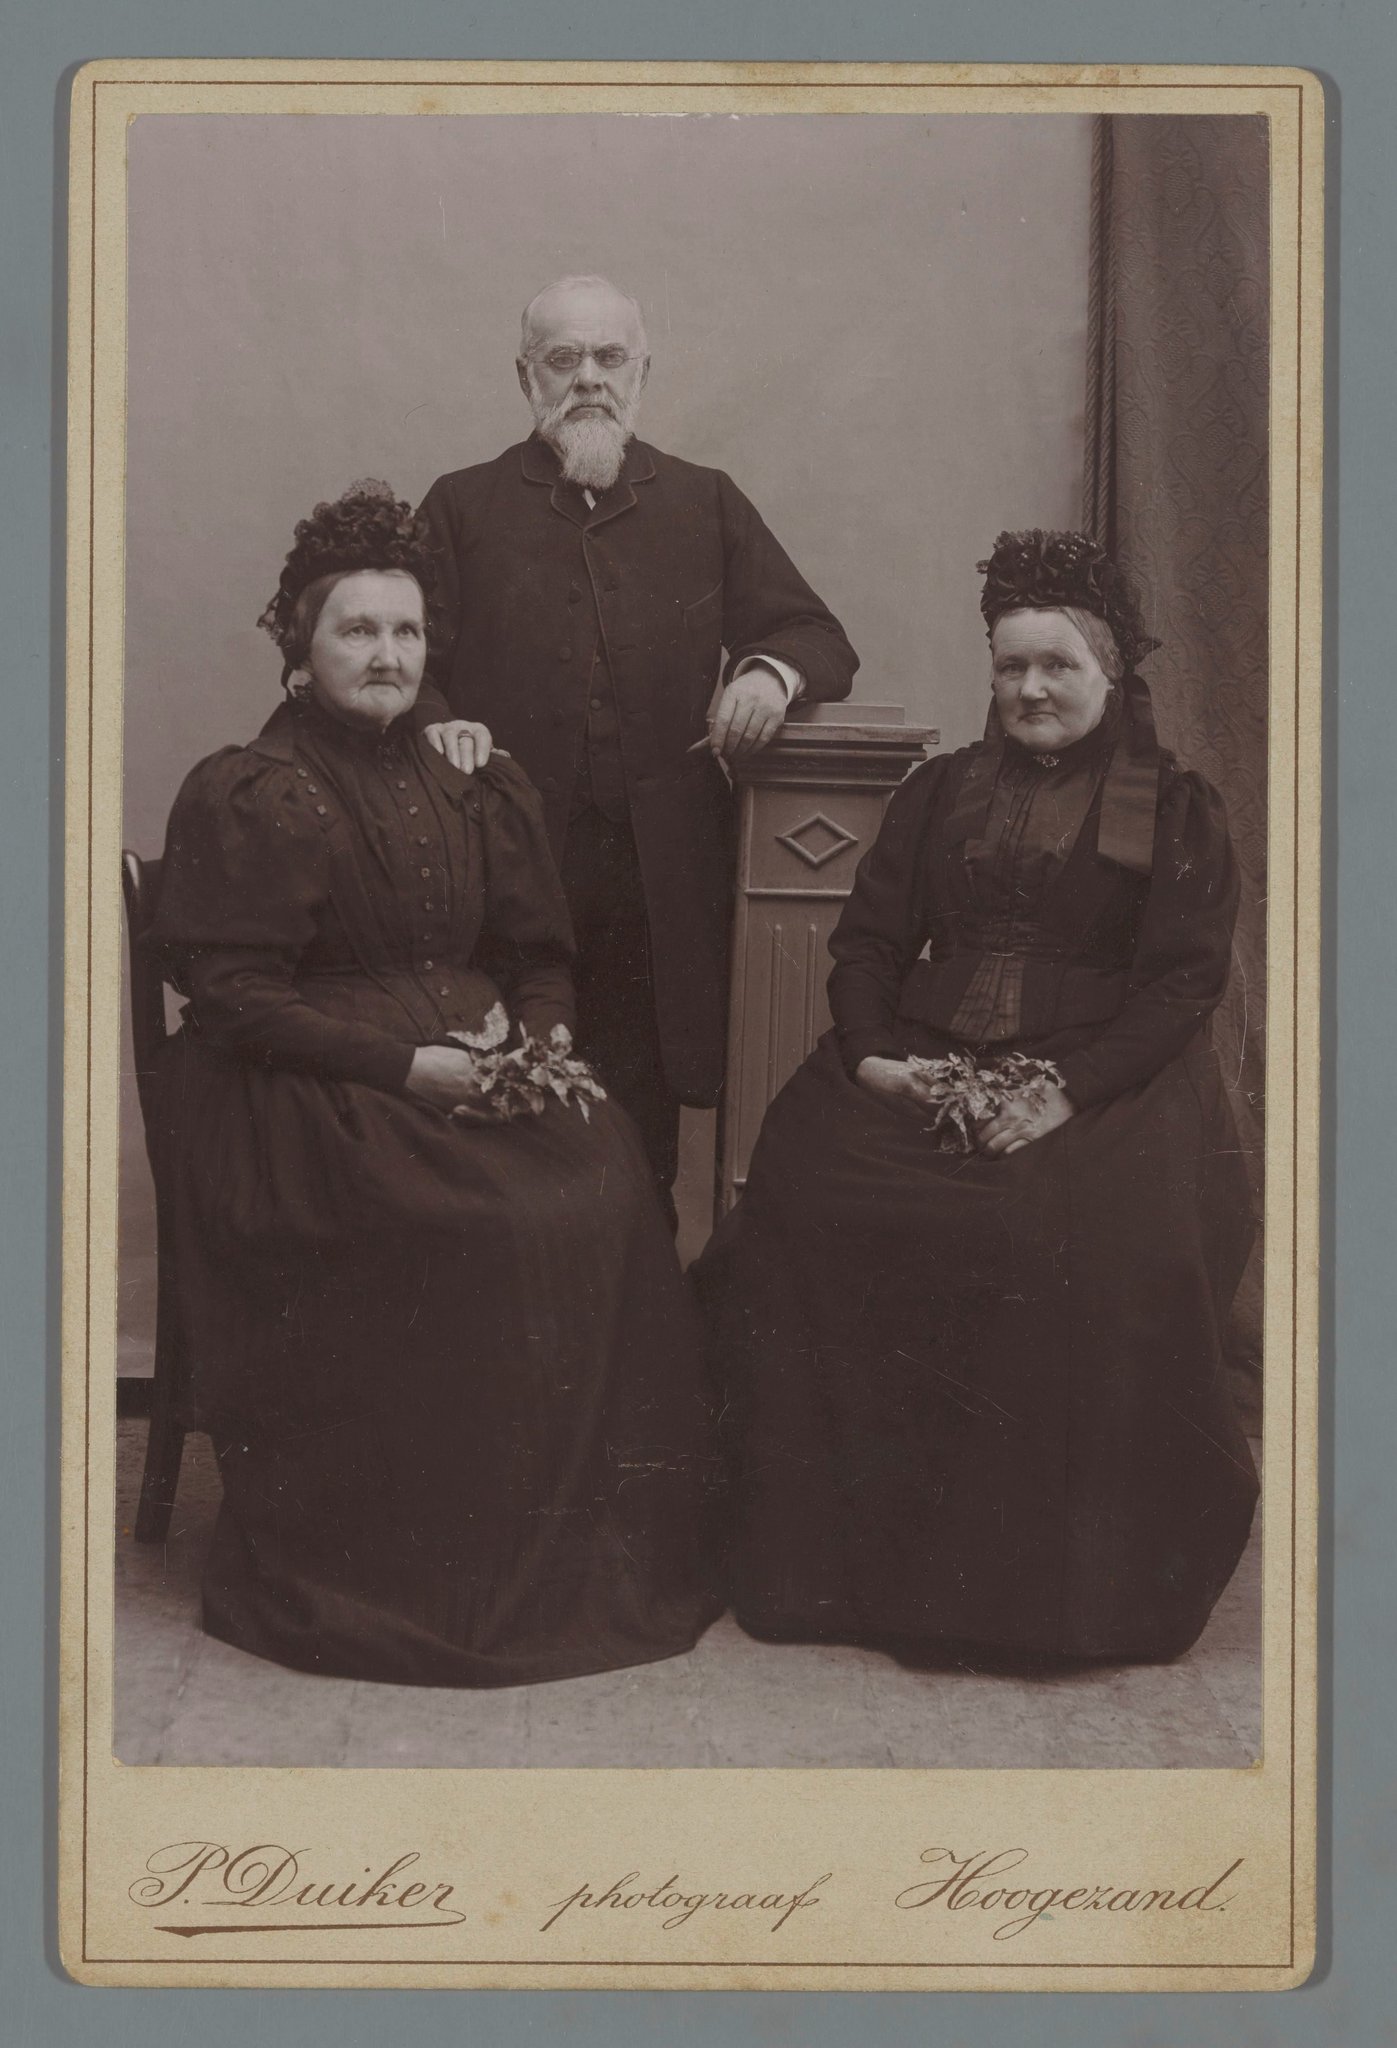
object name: cabinet photograph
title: Groepsportret van twee vrouwen en een man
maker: pieter duiker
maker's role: fotograaf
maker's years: 1853-1936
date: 1890-1900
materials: cardboard, photographic support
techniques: collodion silver print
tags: eyeglasses, spectacles, head-gear, plants (in general) (+ leaf), old man, old woman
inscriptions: : ‘P. Duiker photograaf Hoogezand’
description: De vrouwen hebben bladeren in de handen.